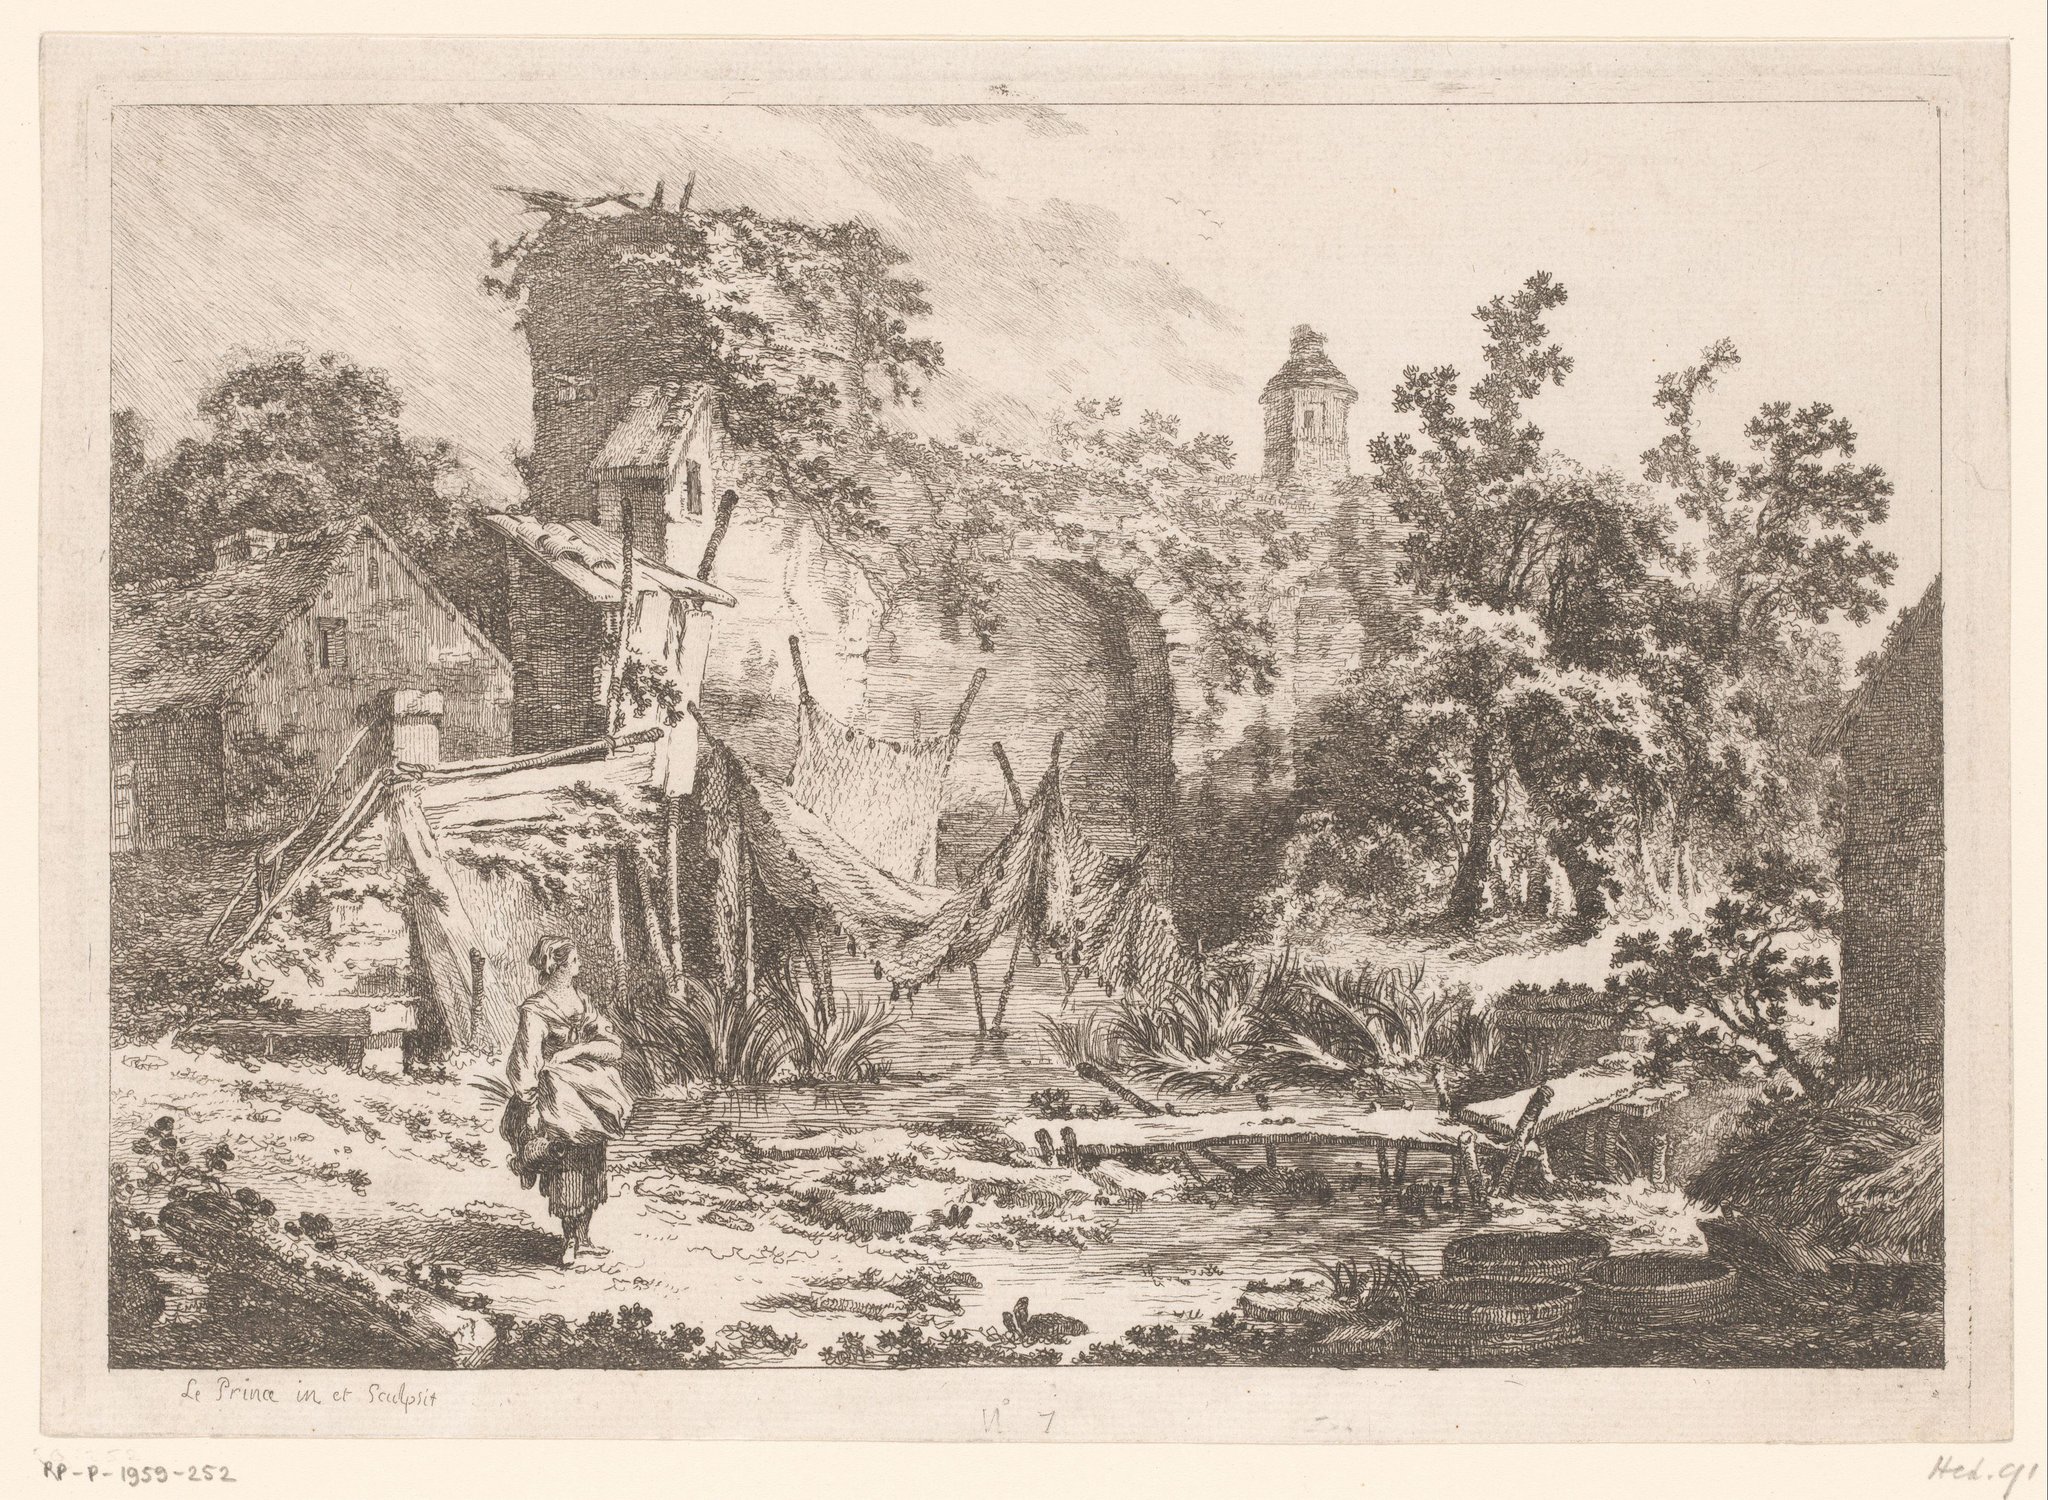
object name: print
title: Vrouw voor een vissershuis met uitgespannen netten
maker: jean baptist leprince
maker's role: draughtsman, print maker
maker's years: 1734-1781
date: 1744-1781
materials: paper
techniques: etching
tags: fishing net, landscape with ruins, cottage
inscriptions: collector's mark: Lugt 2760, collector's mark: Lugt 2228